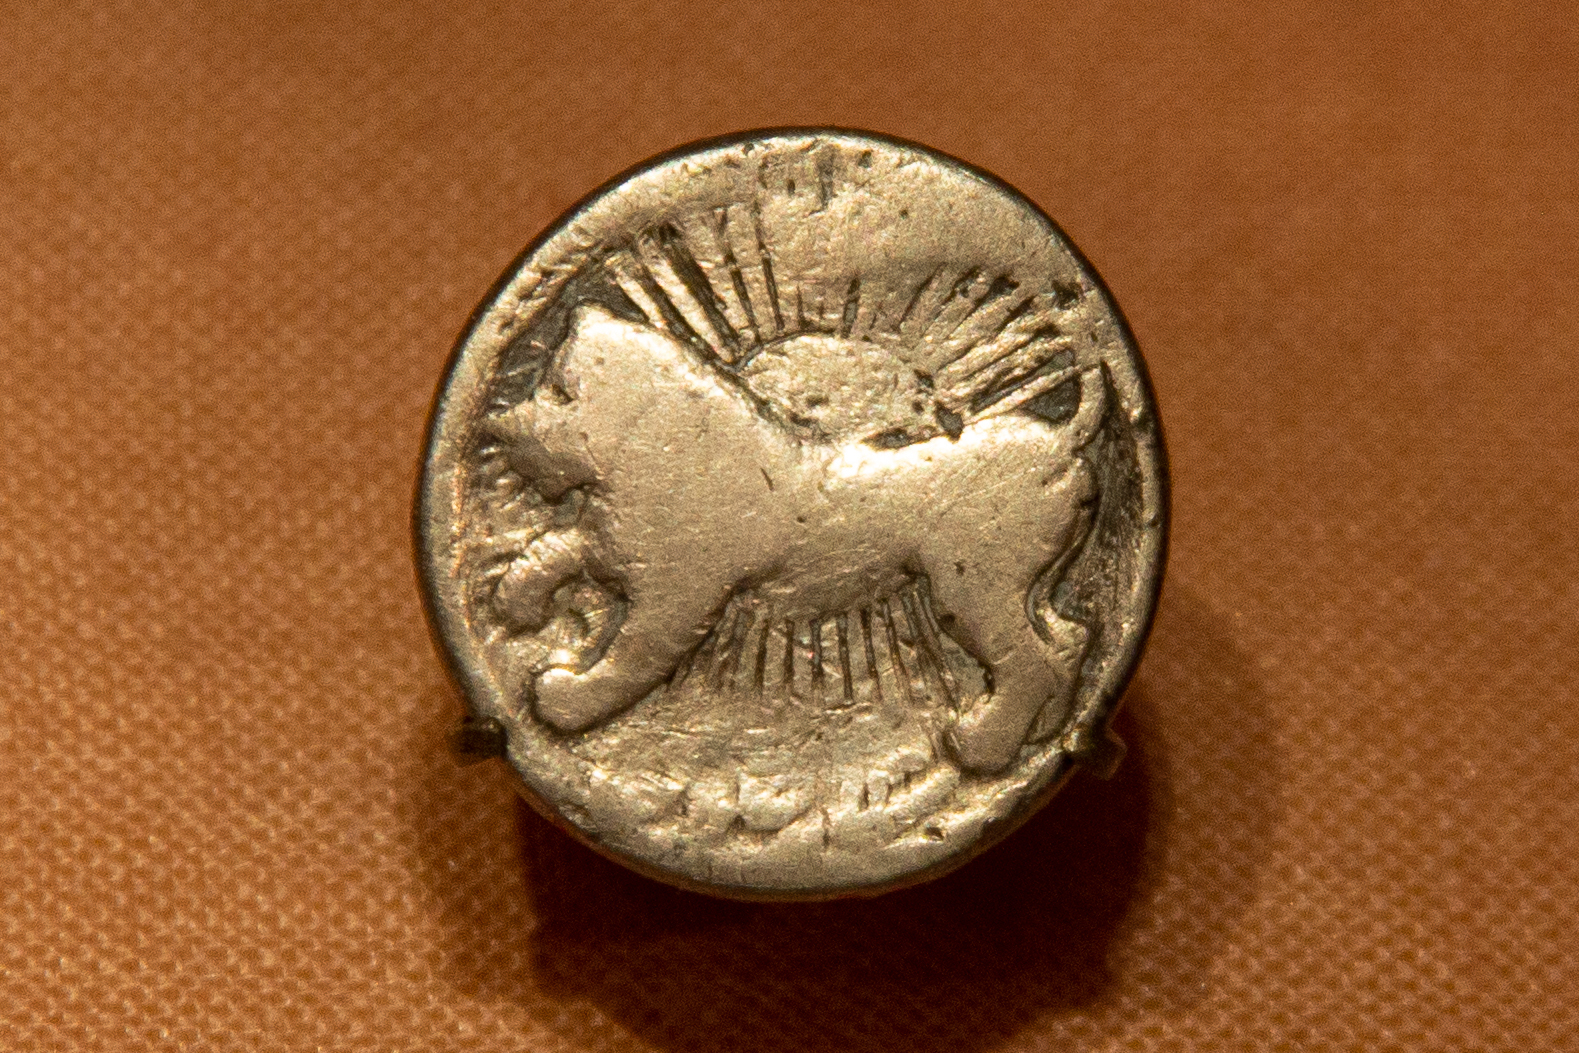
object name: coin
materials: silver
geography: india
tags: lions,zodiac